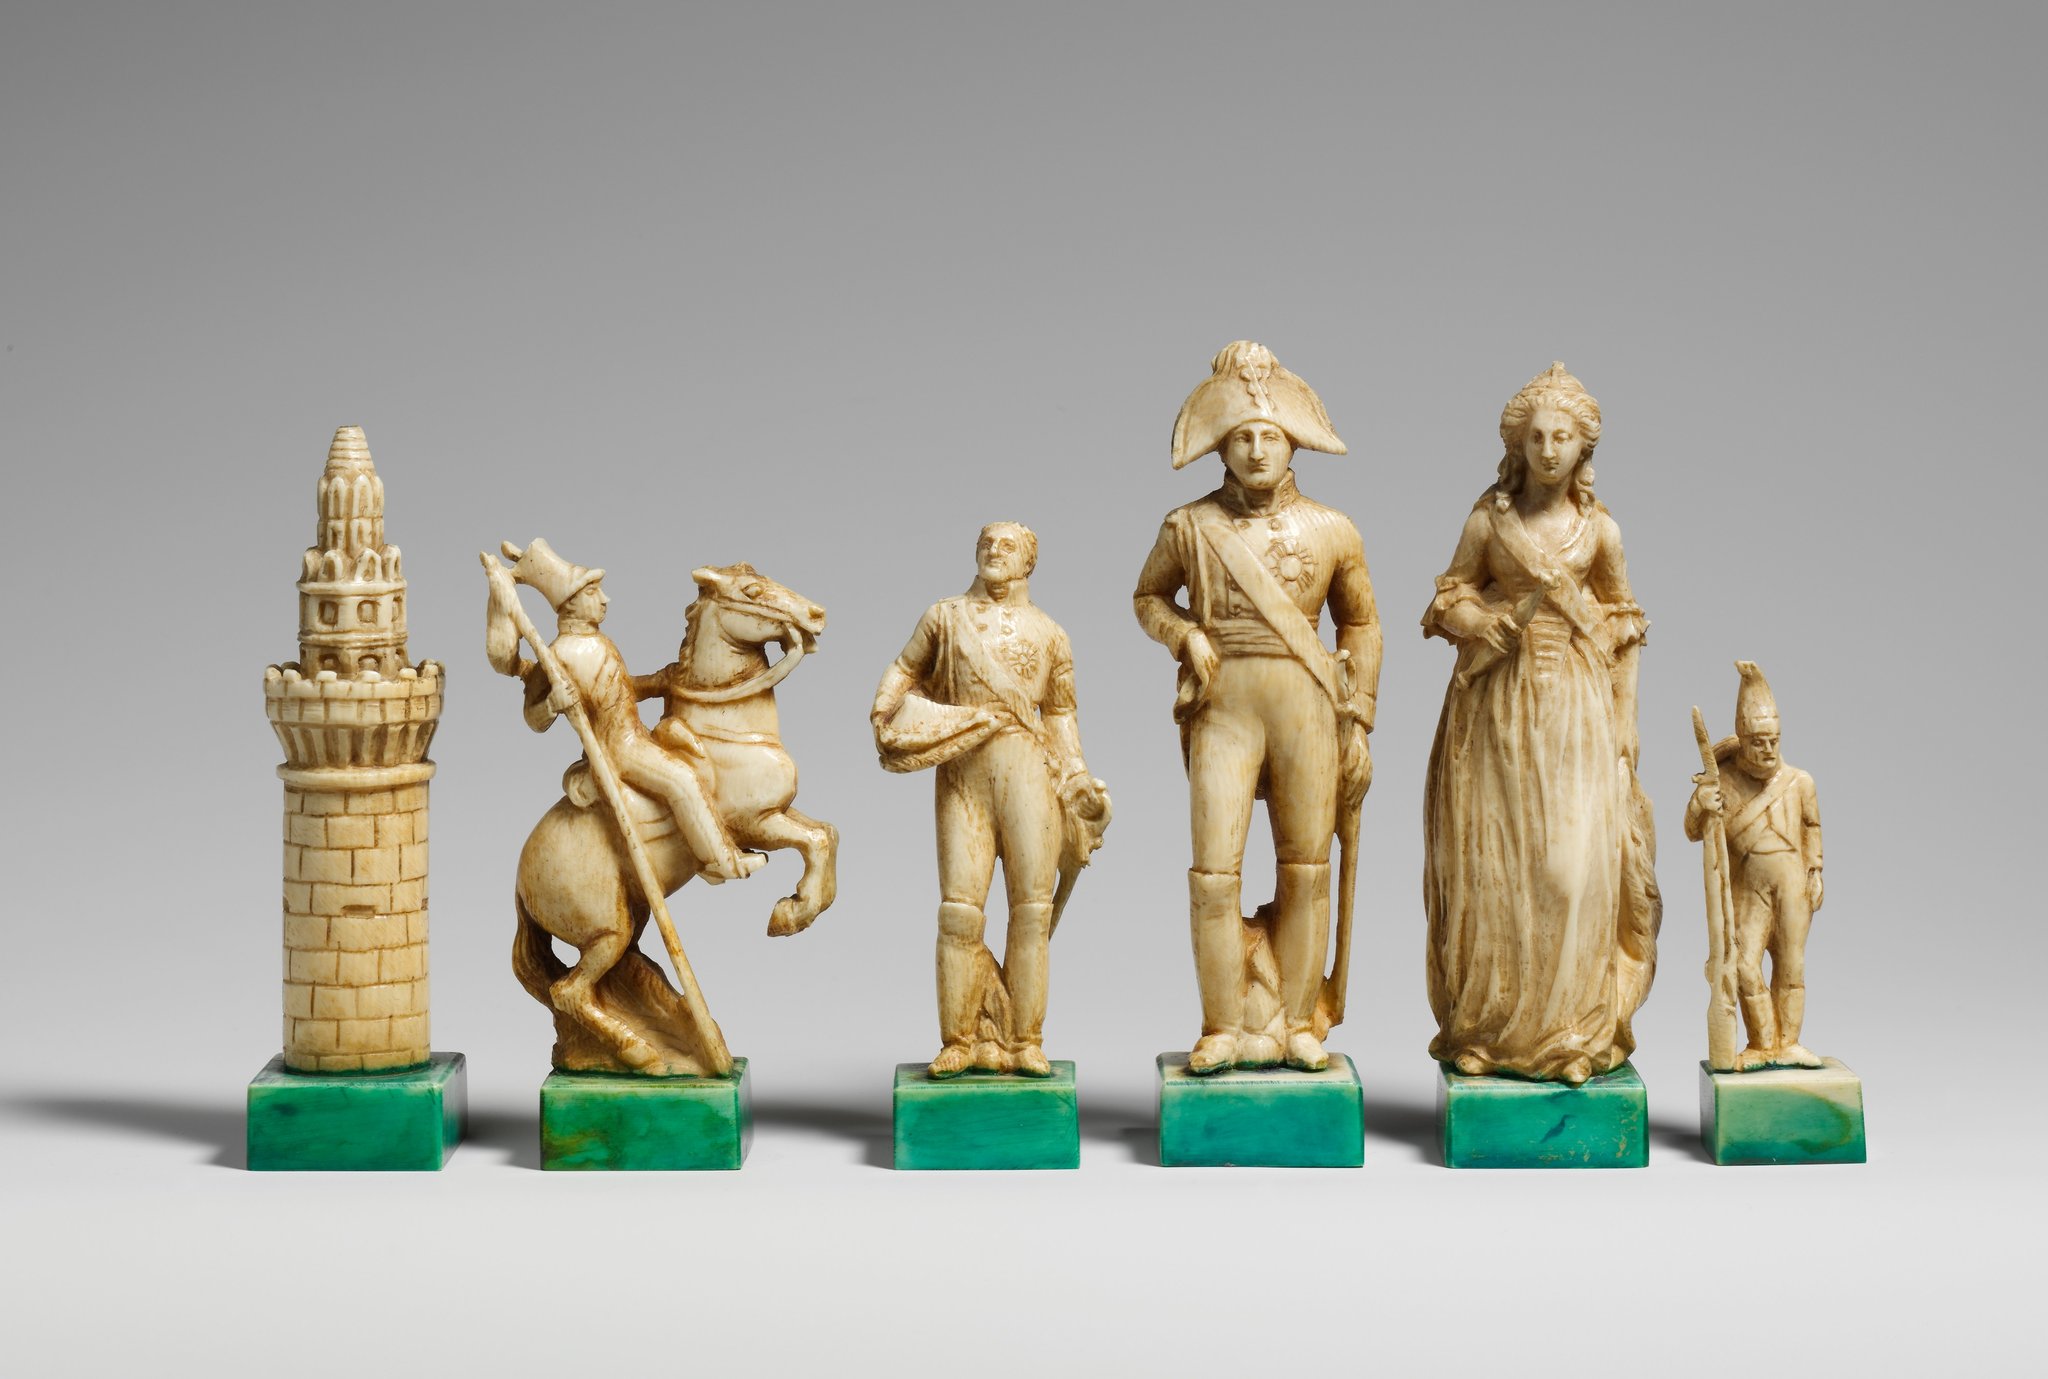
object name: chessman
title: Battle of Austerlitz chessmen (32)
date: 1801-1900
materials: ivory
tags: chess,games